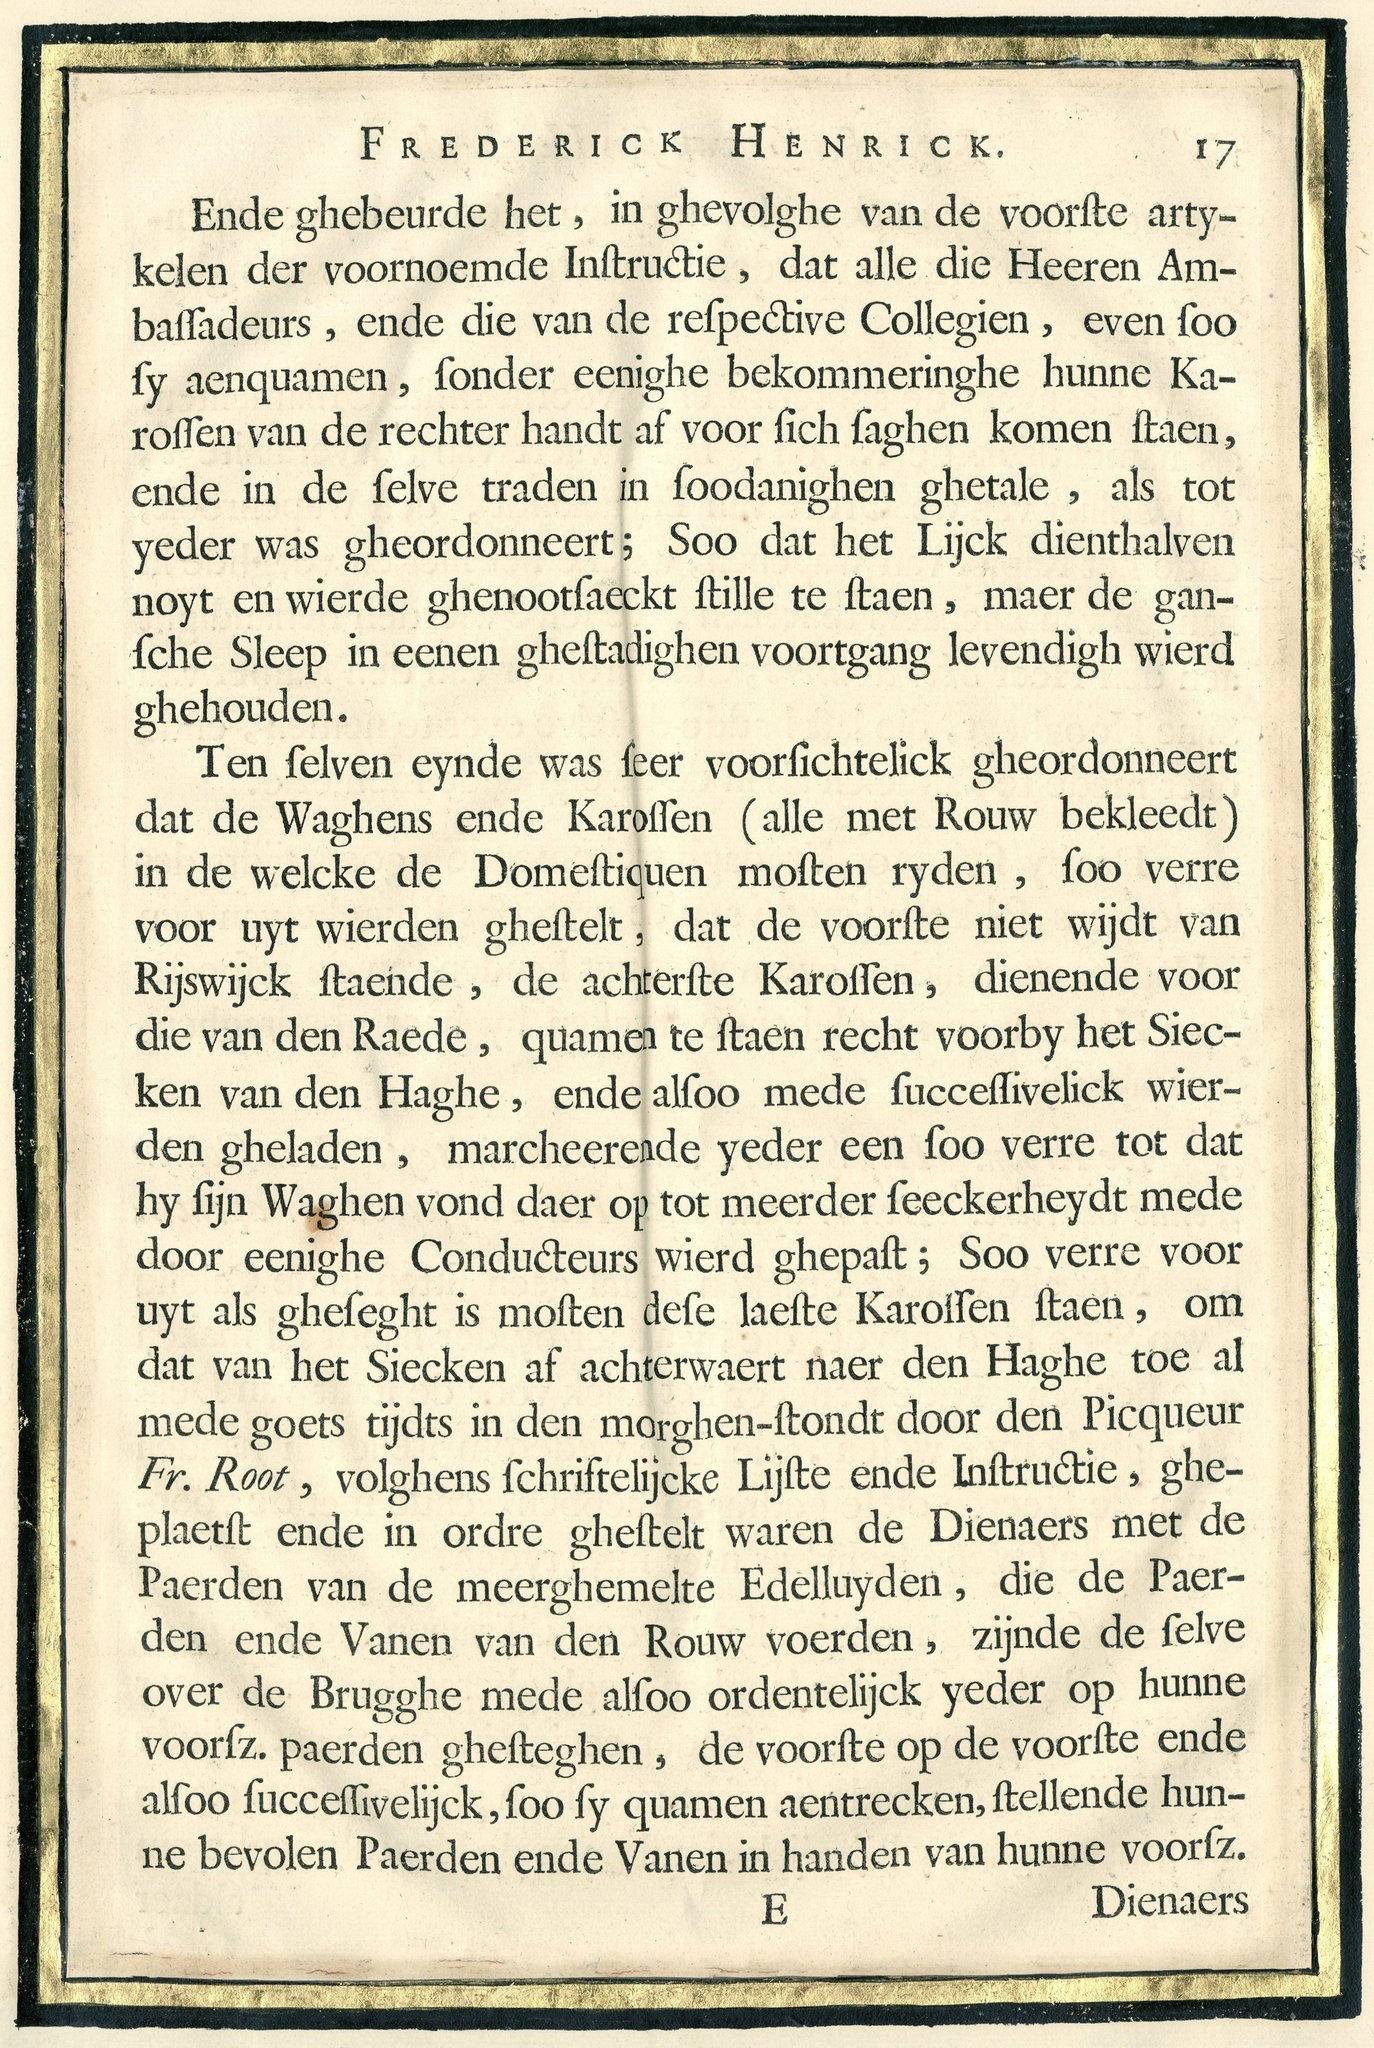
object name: text sheet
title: Begraeffenisse van syne hoogheyt Frederick Henrick. Luxe ingekleurde uitgave van de prenten van de begrafenisstoet van Frederik Hendrik in 1647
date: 1651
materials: paint, paper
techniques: letterpress printing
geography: amsterdam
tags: delft, frederick henry (prince of orange)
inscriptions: date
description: Pagina17 van de beschrijving van de begrafenis van Frederik Hendrik. Blad uitgeknipt, versierd met goud en ingeplakt in de luxe editie uit ca. 1755 van het boek 'Begraeffenisse van syne hoogheyt Frederick Henrick' van Pieter Post, uitgegeven te Amsterdam in 1651.